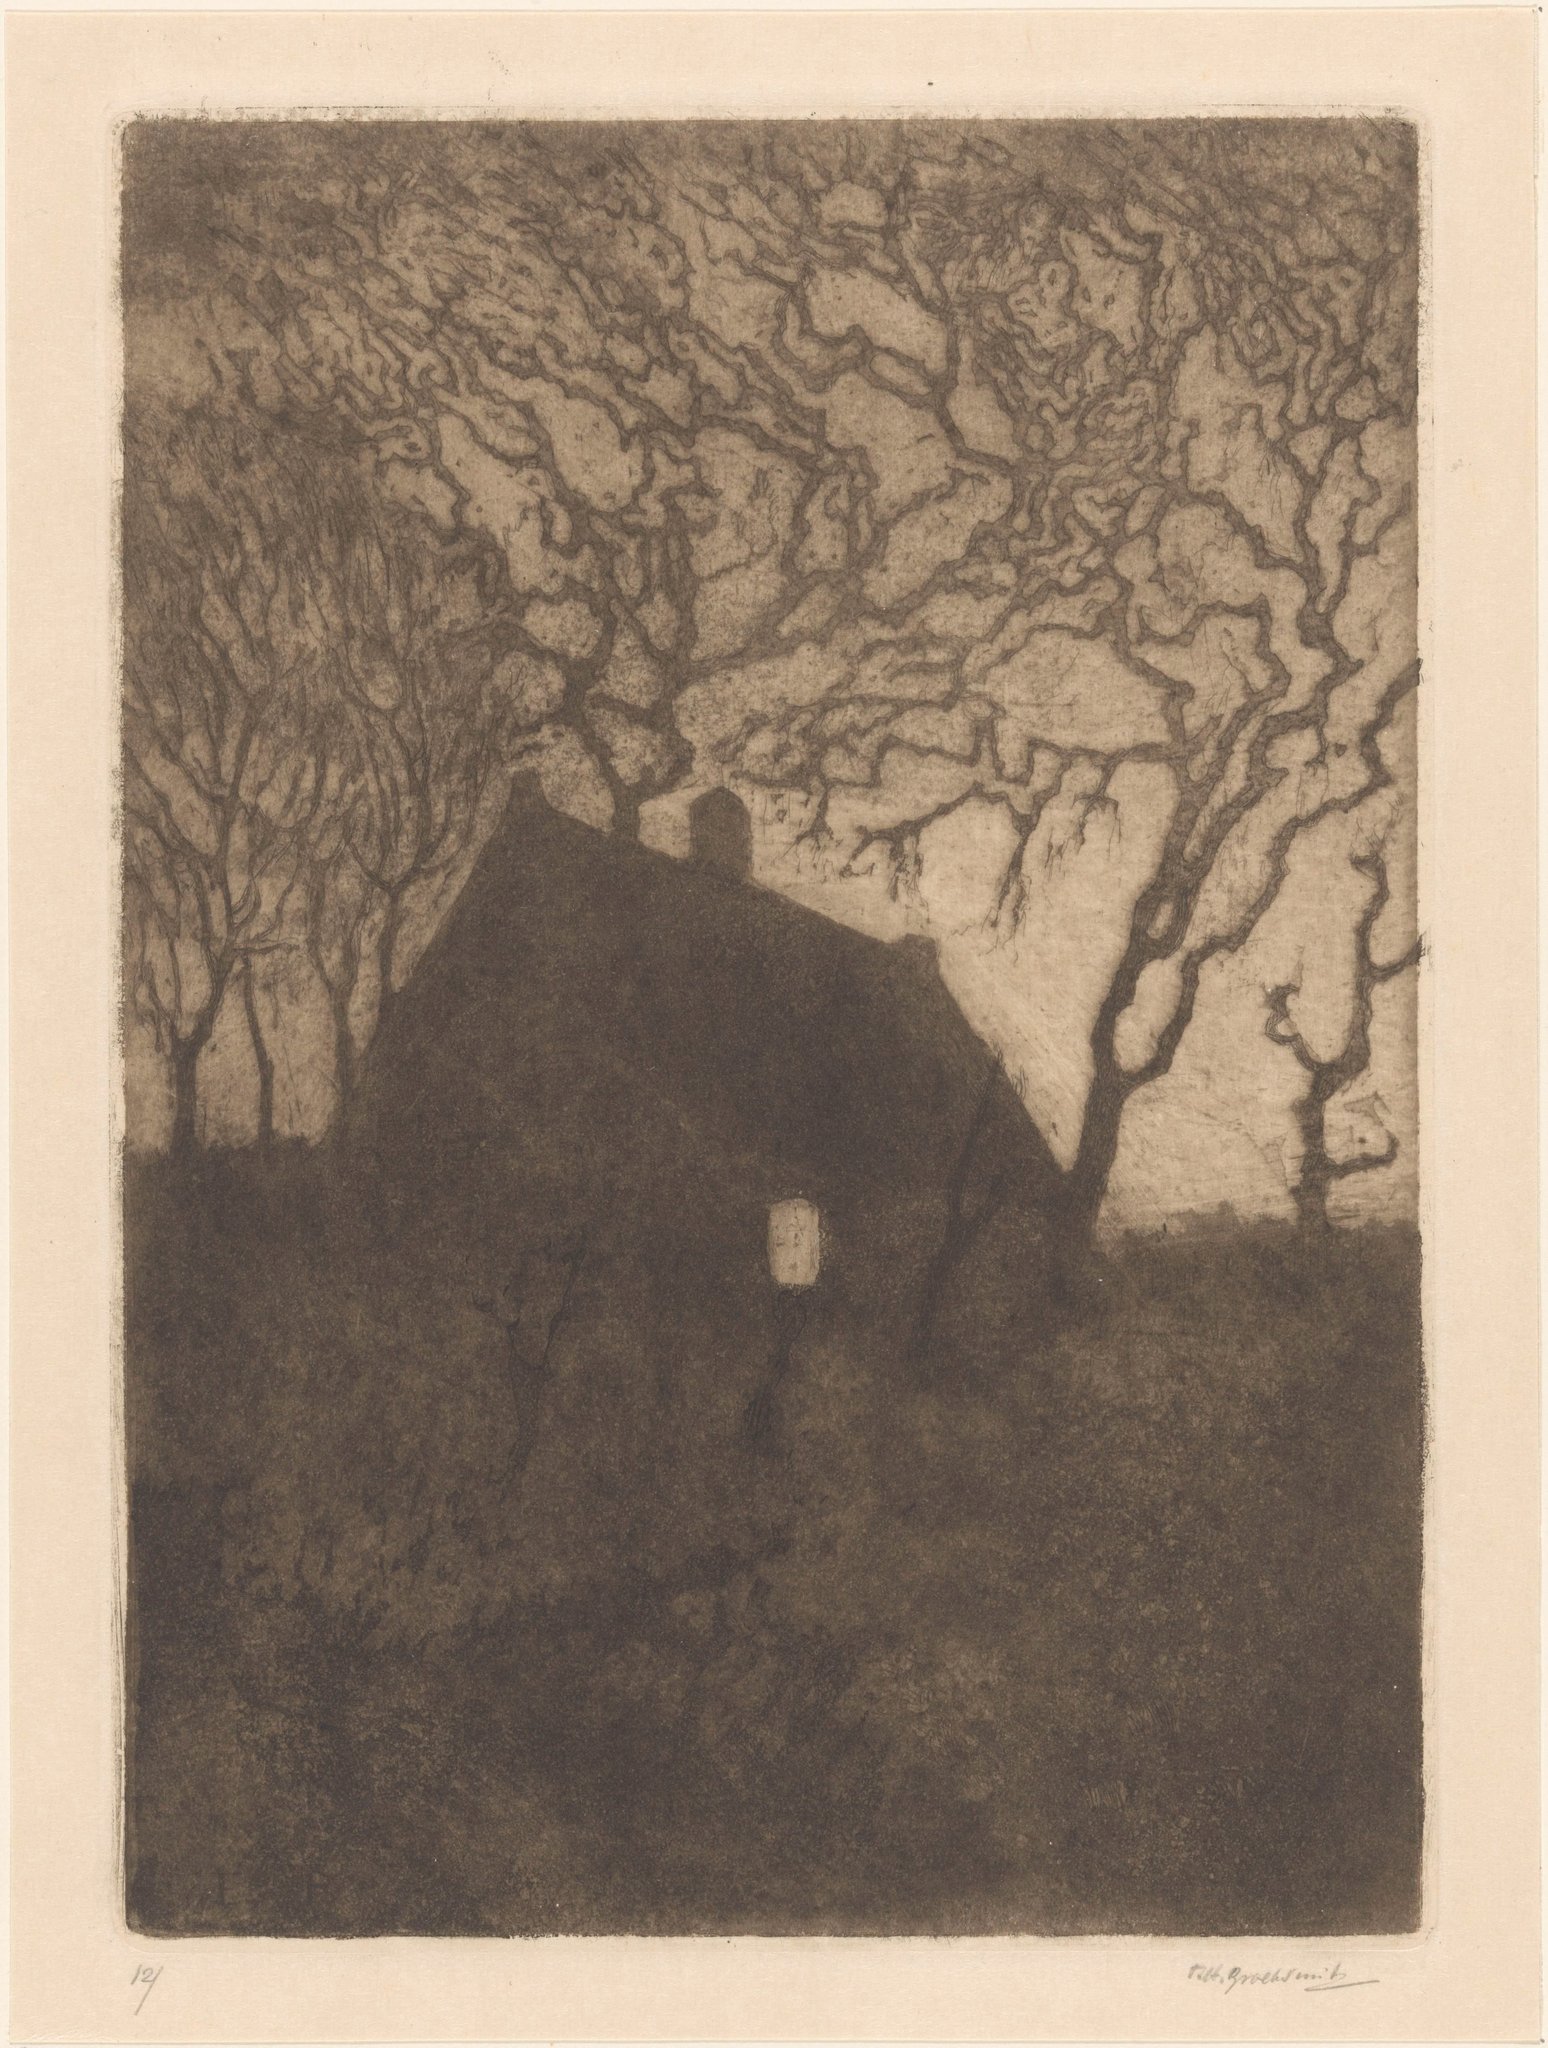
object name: print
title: Huis bij avond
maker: frederika henriëtte broeksmit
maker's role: draughtsman, print maker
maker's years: 1875-1945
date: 1885-1931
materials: paper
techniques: aquatint, etching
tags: trees, evening, farm or solitary house in landscape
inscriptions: collector's mark: Lugt 2228